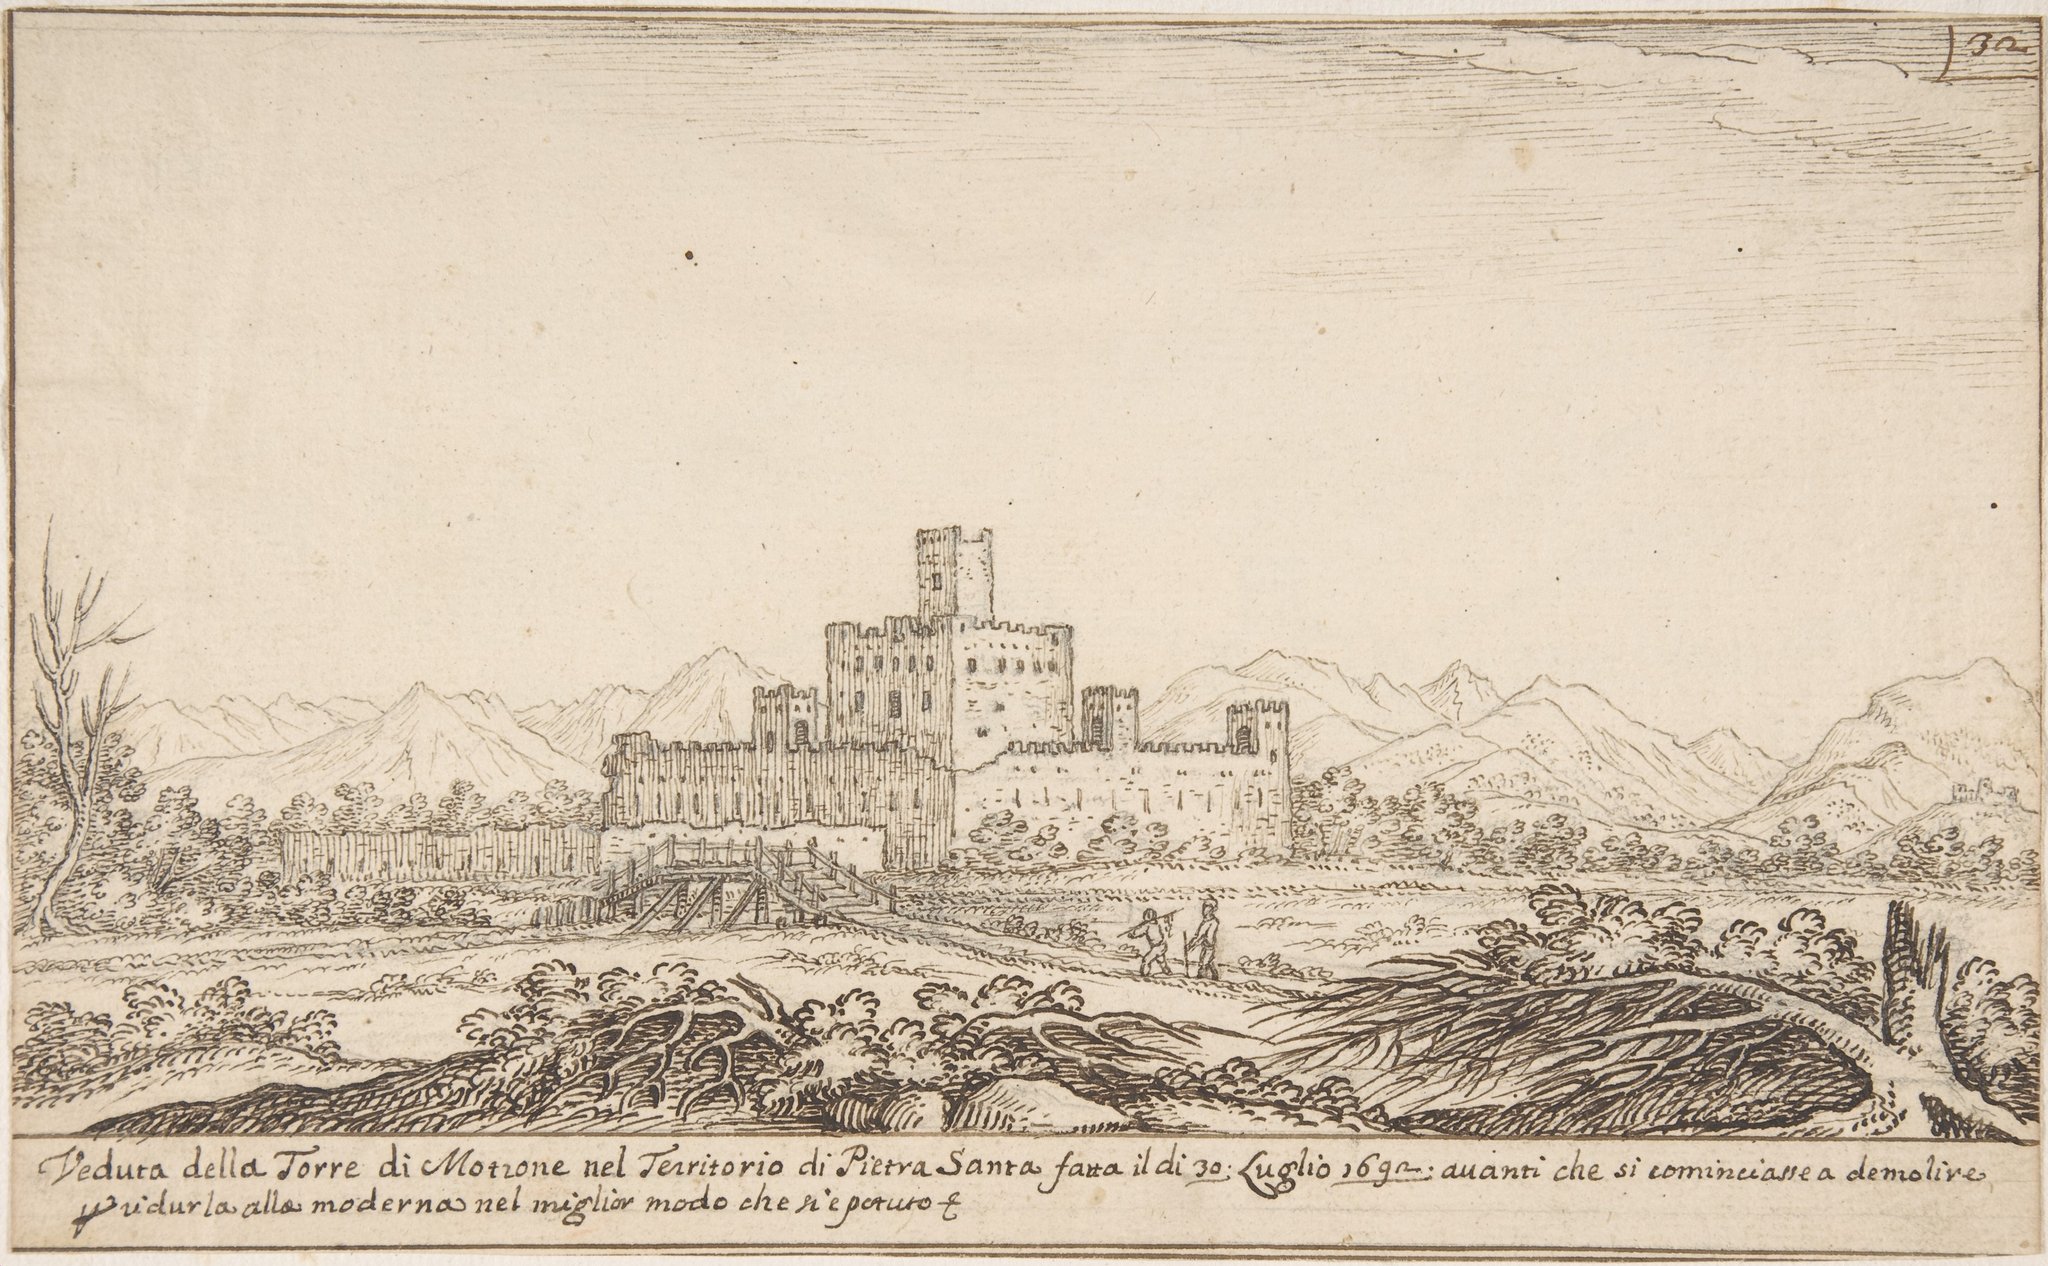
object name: drawing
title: View of Motrone Castle (before its demolition around 1692)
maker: giovanni francesco grimaldi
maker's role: artist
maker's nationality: italian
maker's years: 1606-1680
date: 1606-1680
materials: ink, drawing material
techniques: pen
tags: castles,bridges,mountains